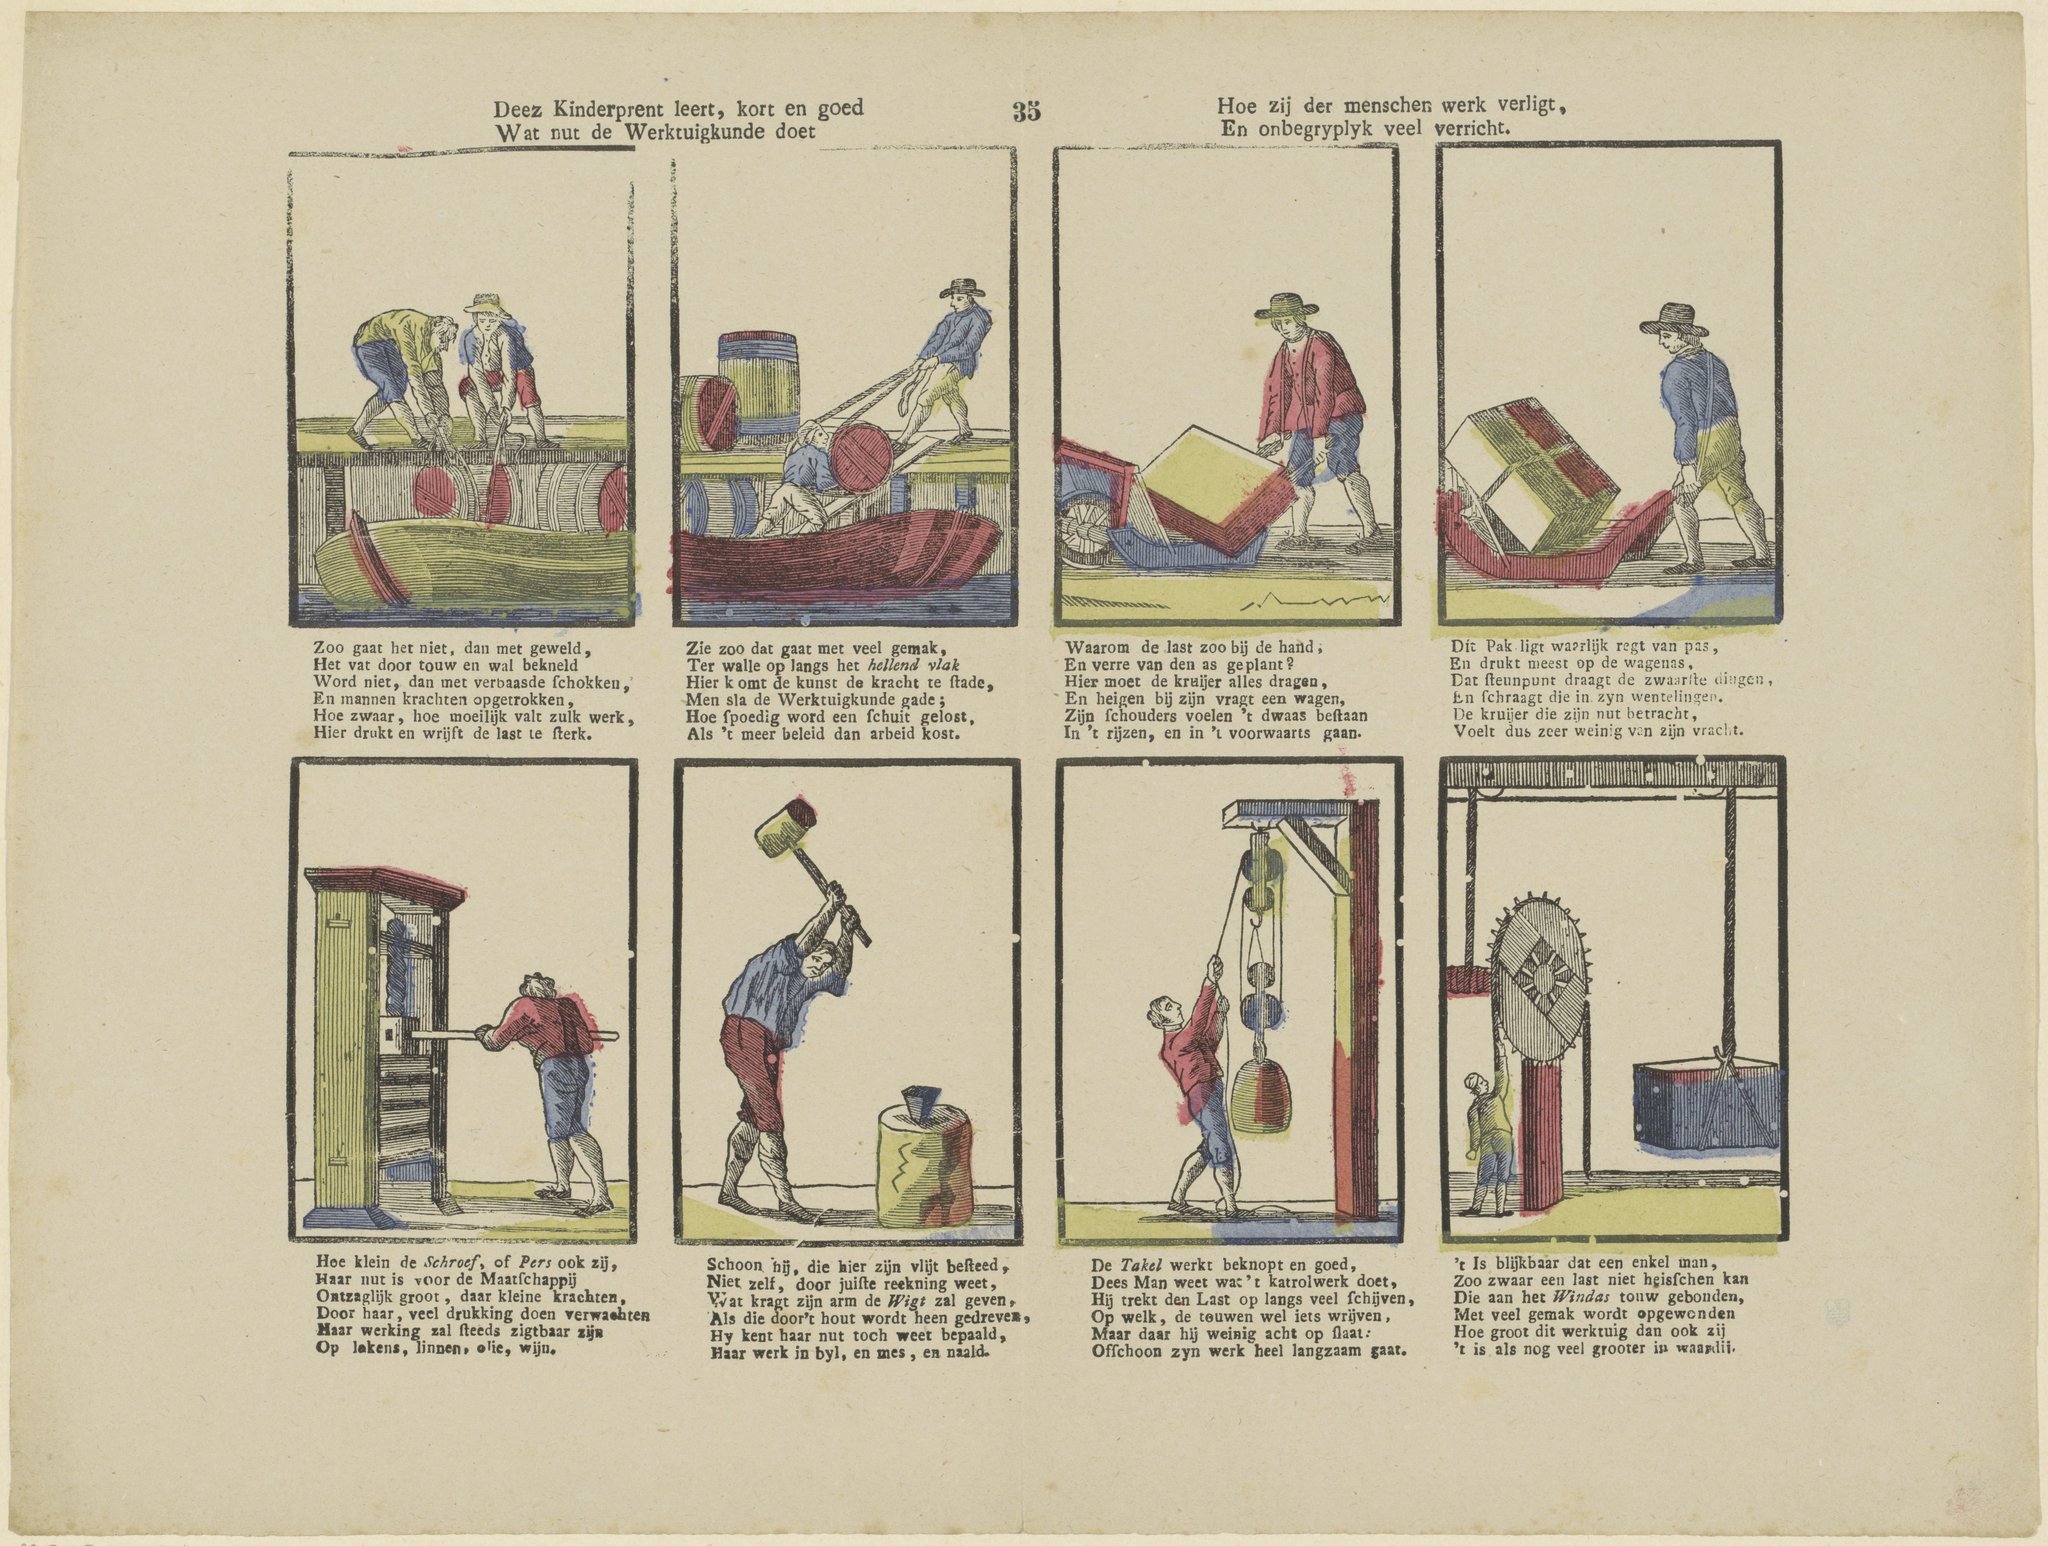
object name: popular print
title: Deez kinderprent leert, kort en goed / Wat nut de werktuigkunde doet / Hoe zij der menschen werk verligt, / En onbegryplyk veel verricht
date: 1866-1902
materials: paper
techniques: colour, letterpress printing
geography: turnhout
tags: tools and machines ~ building, printing press, dock crane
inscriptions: collector's mark: Lugt 2760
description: Blad met 8 voorstellingen van mannen die werktuigen gebruiken, zoals een pers en een hijskraan. Onder elke afbeelding een zesregelig vers. Genummerd midden boven: 35.